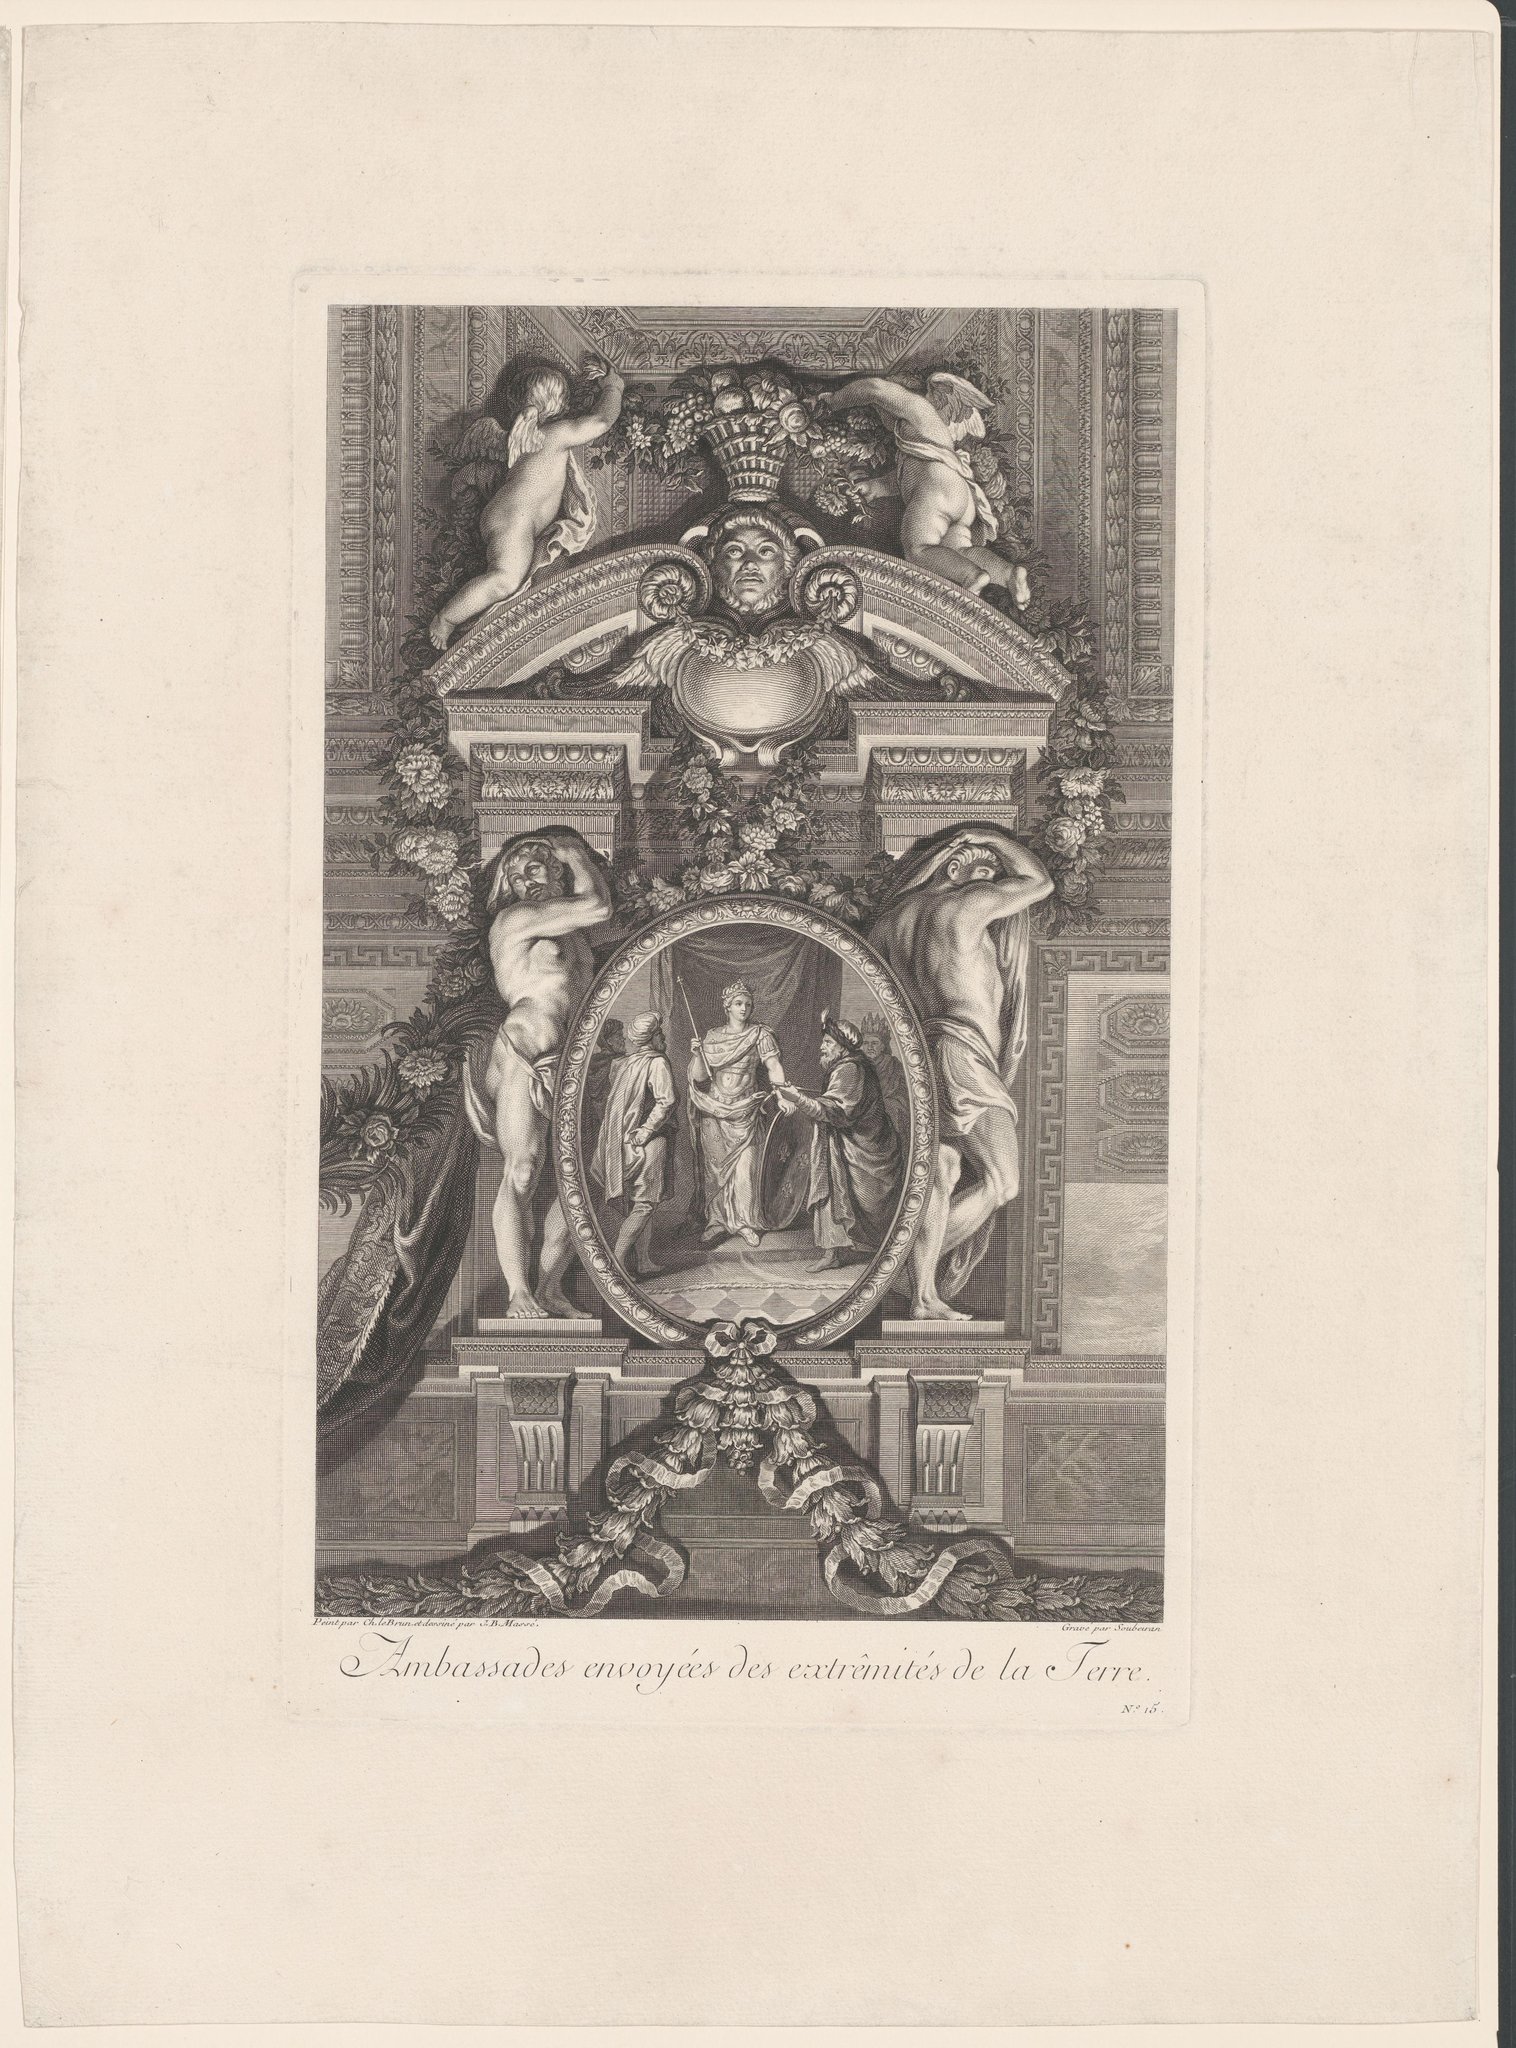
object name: print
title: Werken van Charles le Brun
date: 1752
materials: paper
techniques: engraving, etching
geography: paris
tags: wall-covering, reception ~ ambassador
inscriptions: collector's mark: Lugt 2228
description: Prent uit: Massé, Jean Baptiste. La Grande Galerie de Versailles, et les deux salons qui l'accompagnent, peints par Charles le Brun premier peintre de Louis XIV, dessinés par Jean- Baptiste Masse peintre et conseiller de l'Academie royale de peinture & sculpture; et gravés sous ses yeux par les meilleurs maitres du tems. Parijs: Imprimerie Royale, 1752.